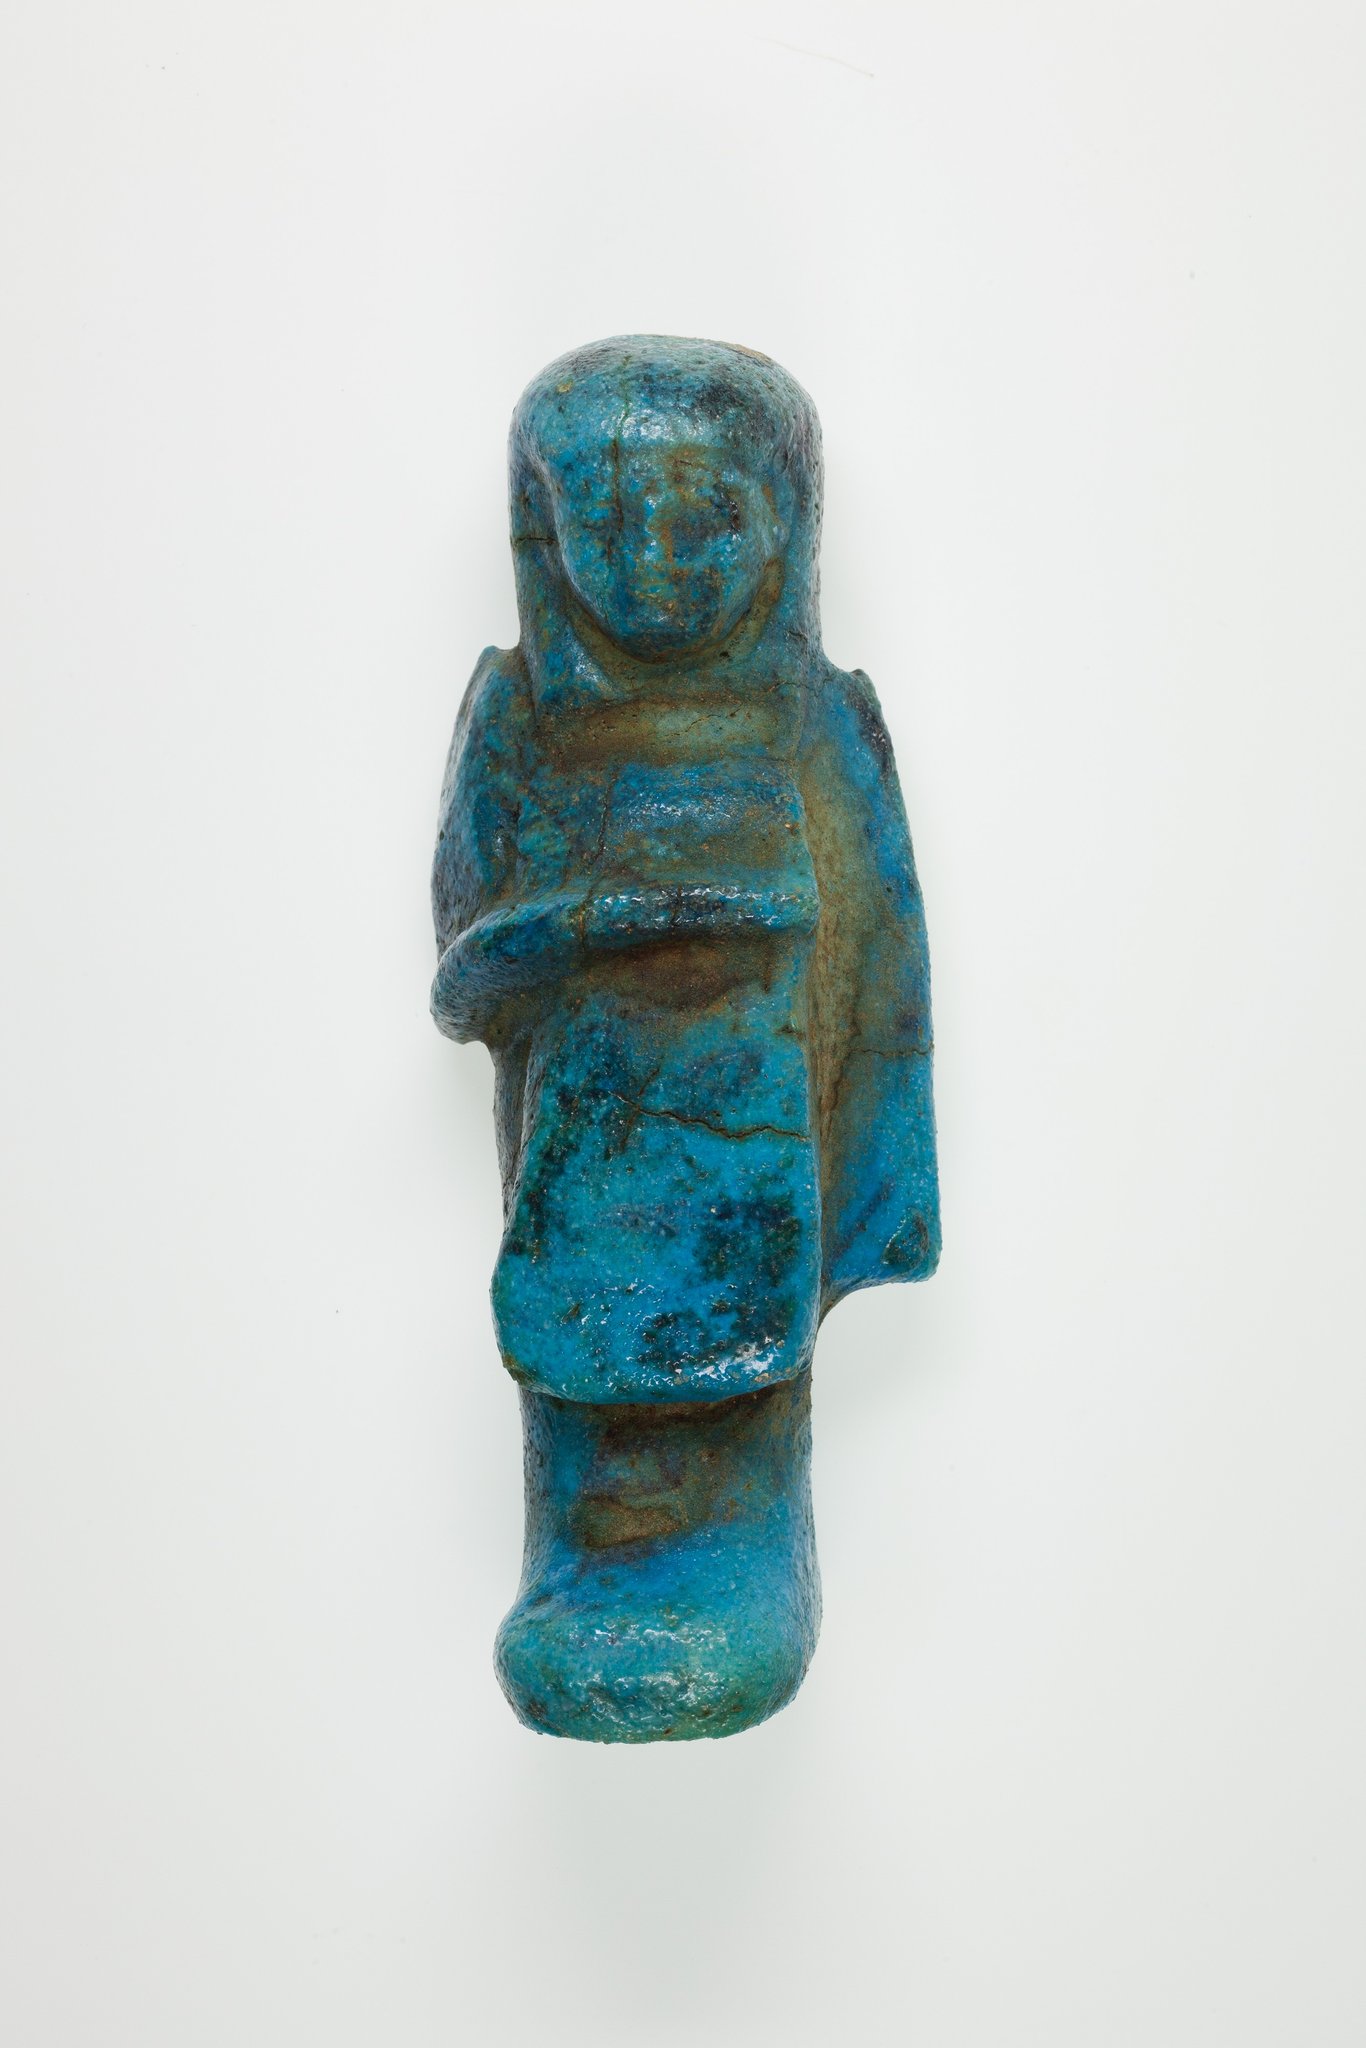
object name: overseer shabti, henettawy c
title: Overseer Shabti of Henettawy (C), Daughter of Isetemkheb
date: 990-970 BCE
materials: faience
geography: egypt